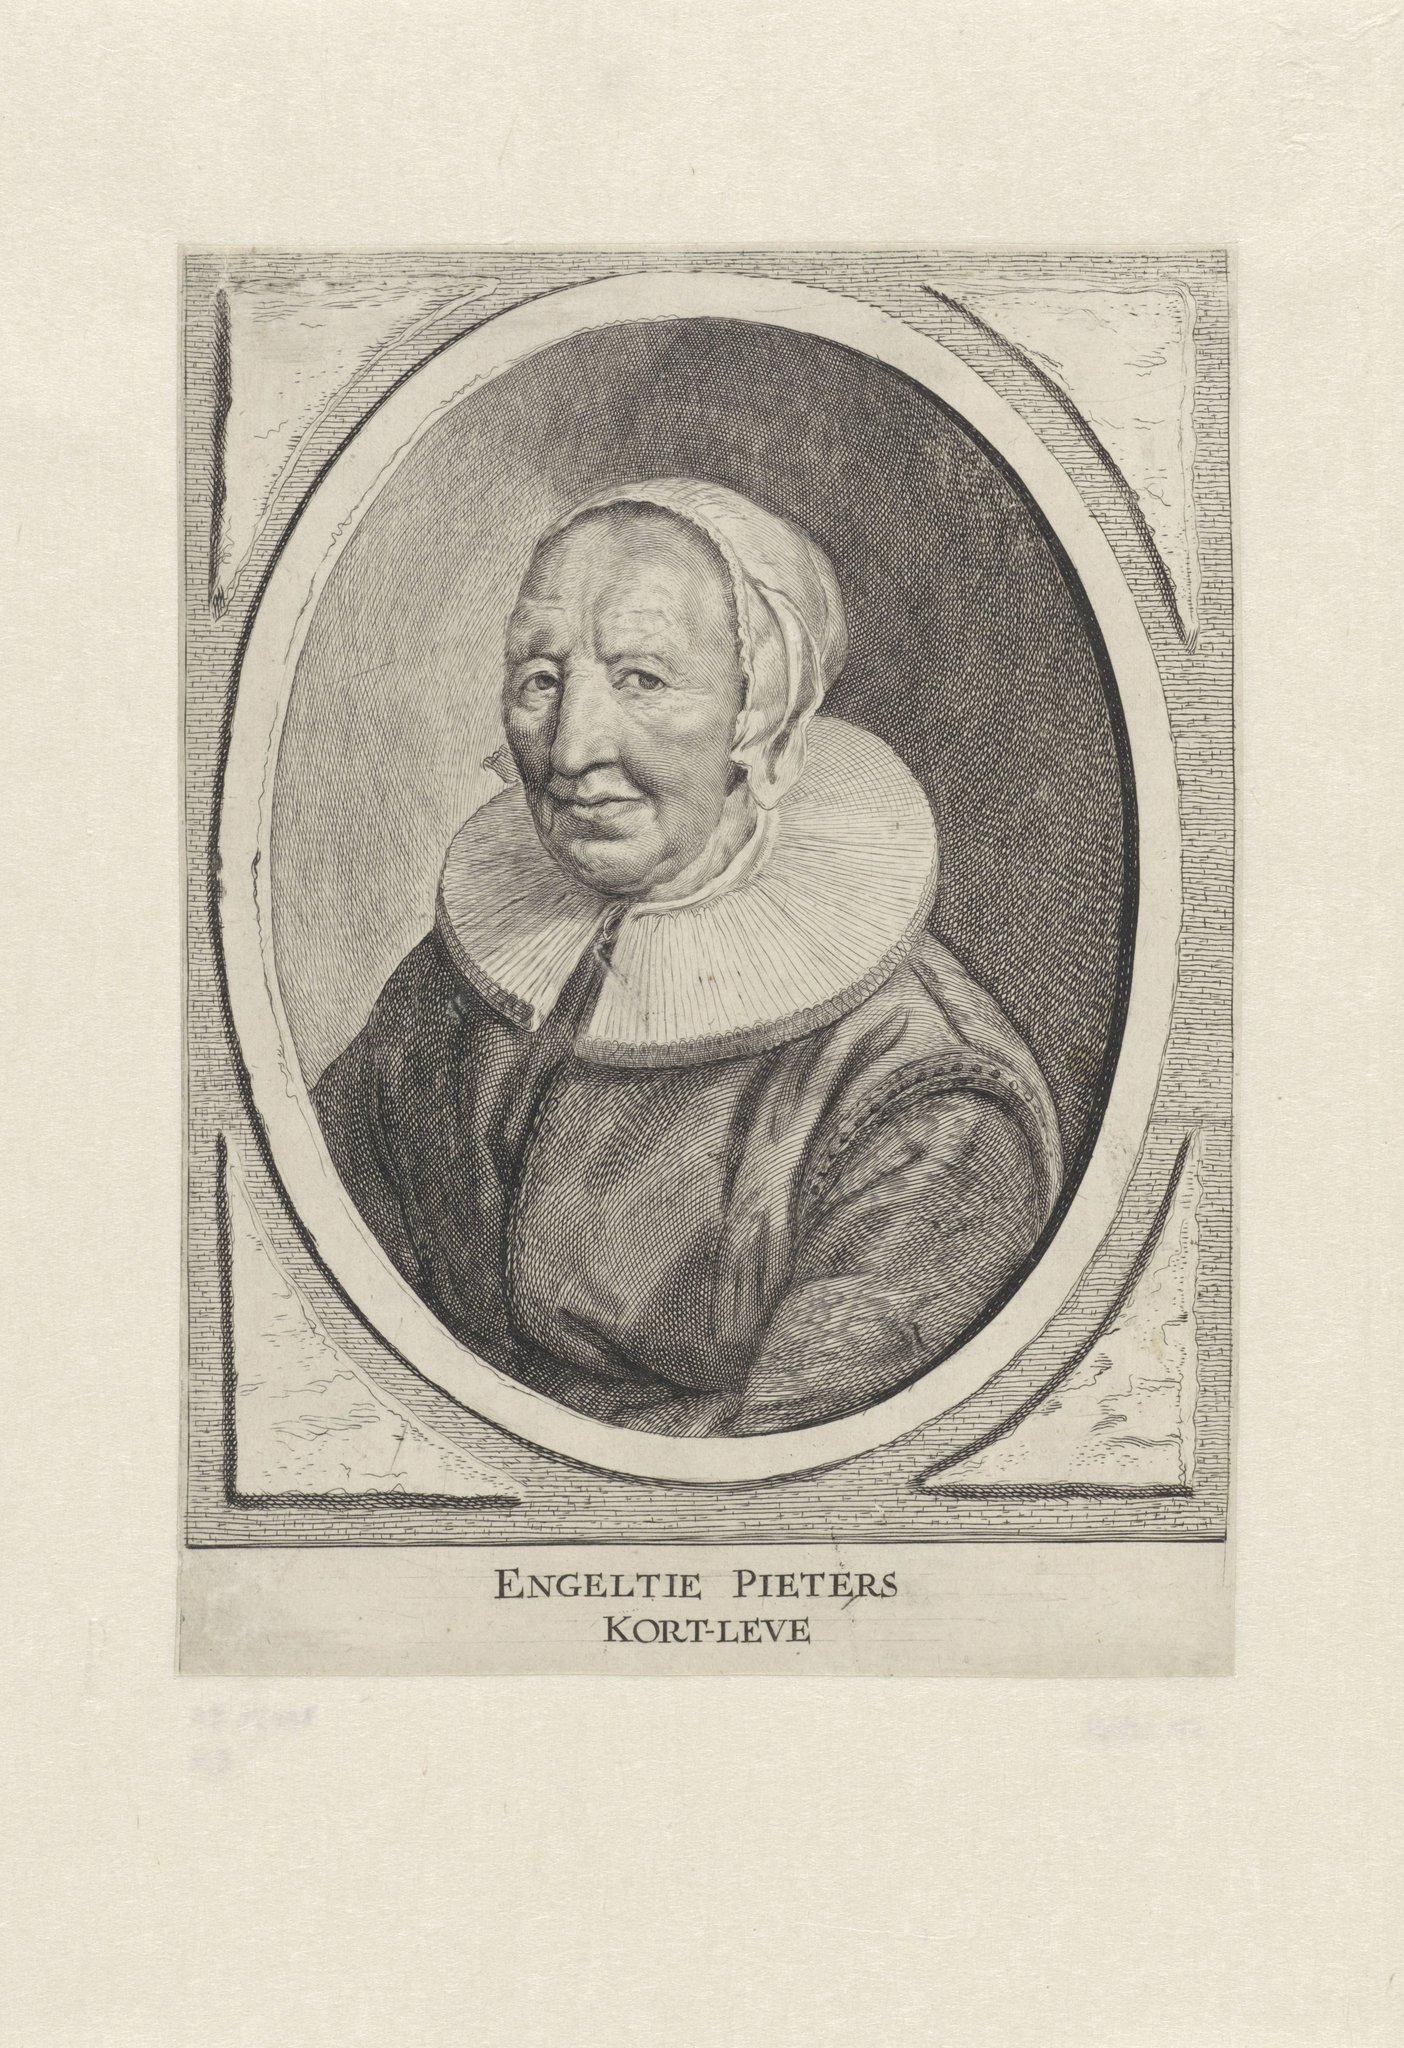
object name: print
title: Engeltie Pieters / Kort-Leve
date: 1638-1658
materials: paper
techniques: engraving, etching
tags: neck-gear: collar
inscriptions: collector's mark: Lugt 240